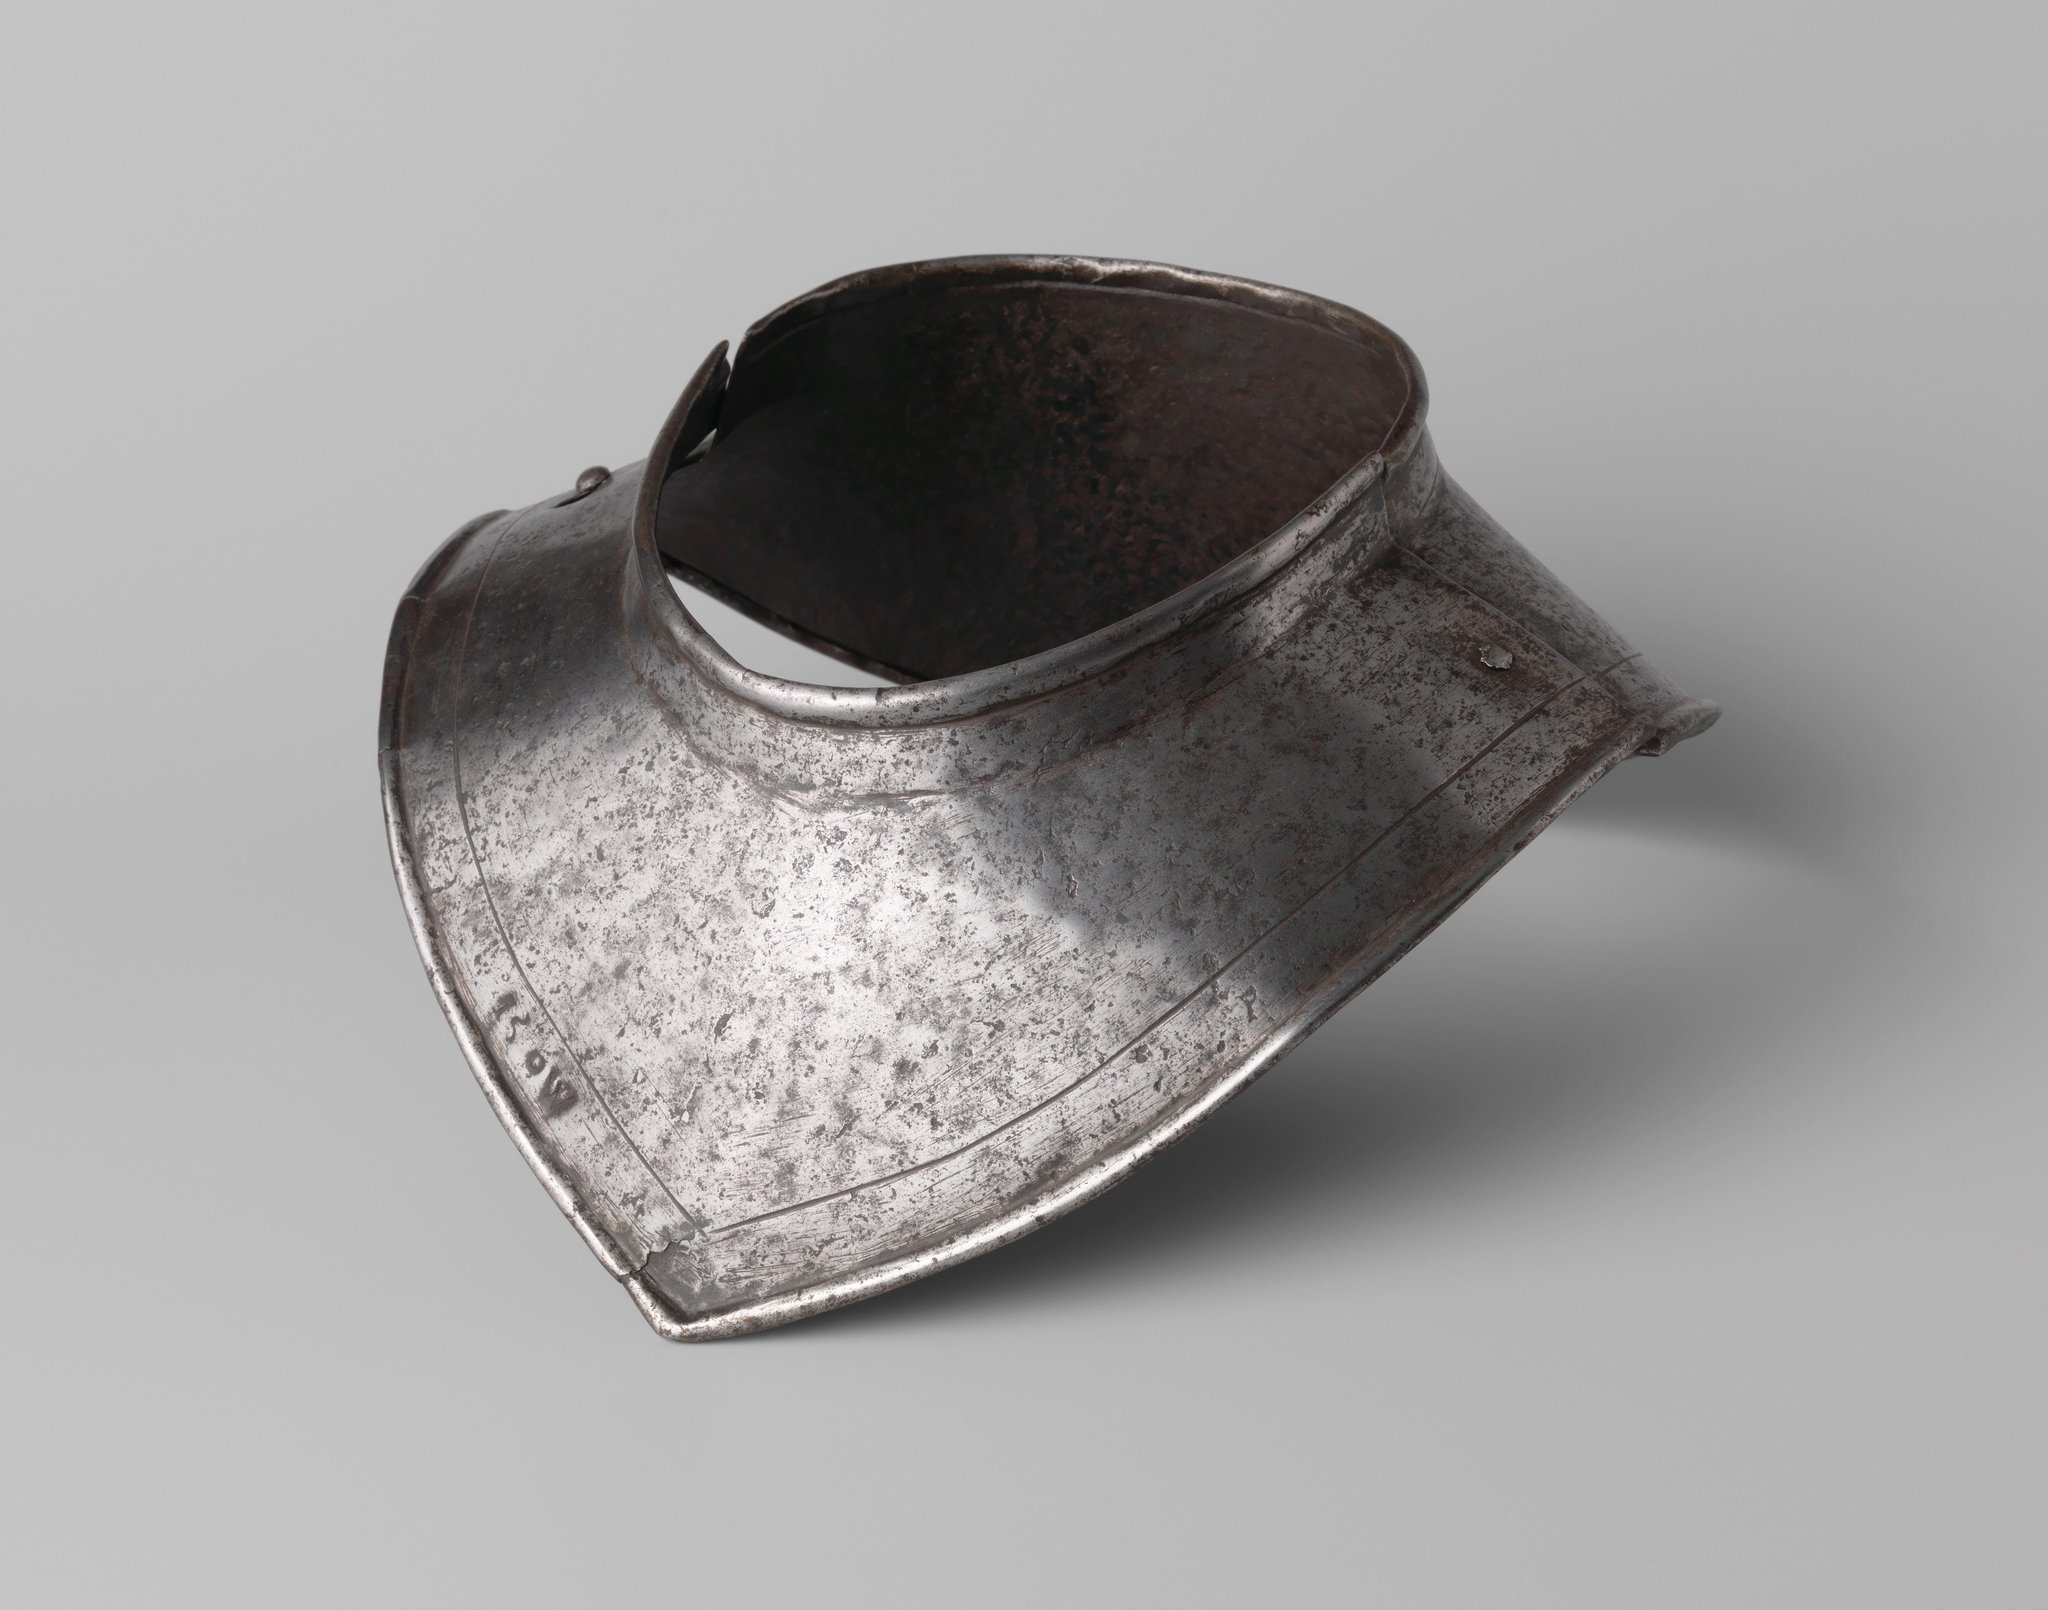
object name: gorget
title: Ringkraag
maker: Anonymous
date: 1599-1699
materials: iron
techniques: forging, striking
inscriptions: number: ‘150 W’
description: Ringkraag, blank, ijzer, bestaat uit twee delen die aan weerzijden aan elkaar zijn vastgeklonken. Links van de halsopening is een opening waarmee de ringkraag kan worden geopend. De randen van de kraag zijn omgeflenst, parallel lopend aan de rand een enkele lijn die ter decoratie dient. Binnenzijde is zwart geverfd.